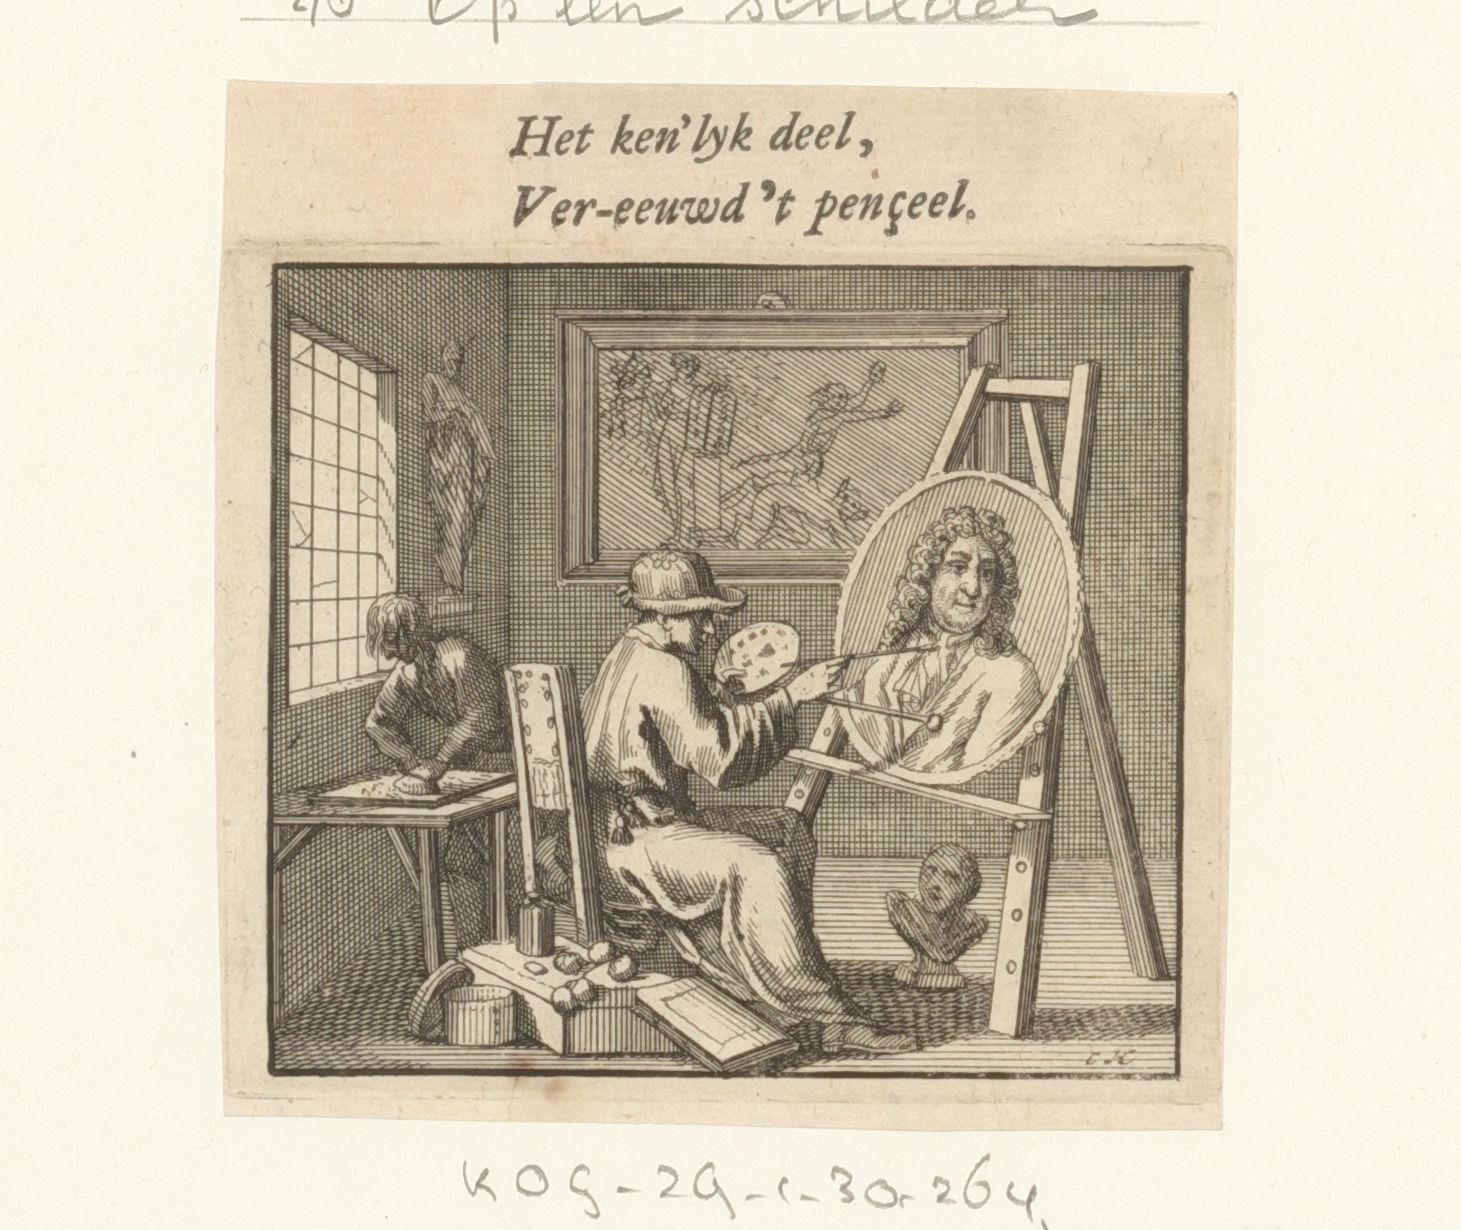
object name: print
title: Het ken'lyk deel, Ver-eeuwd 't pençeel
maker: cornelis huyberts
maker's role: print maker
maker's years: 1669-1709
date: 1725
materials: paper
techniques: etching, letterpress printing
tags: artist at work with assistants or pupils, artist at work, in his workshop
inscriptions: stamp, collector's mark: Lugt 1641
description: Prent uit: Graauwhart, Hendrik. Voorbeeldelyke zeede-lessen, genoomen uyt den eersten toestand des werelds (...). Amsterdam: Johannes Ratelband, 1725. Prent ook gebruikt voor eerdere en (1709) latere uitgave (1756, 1761 en 1764).